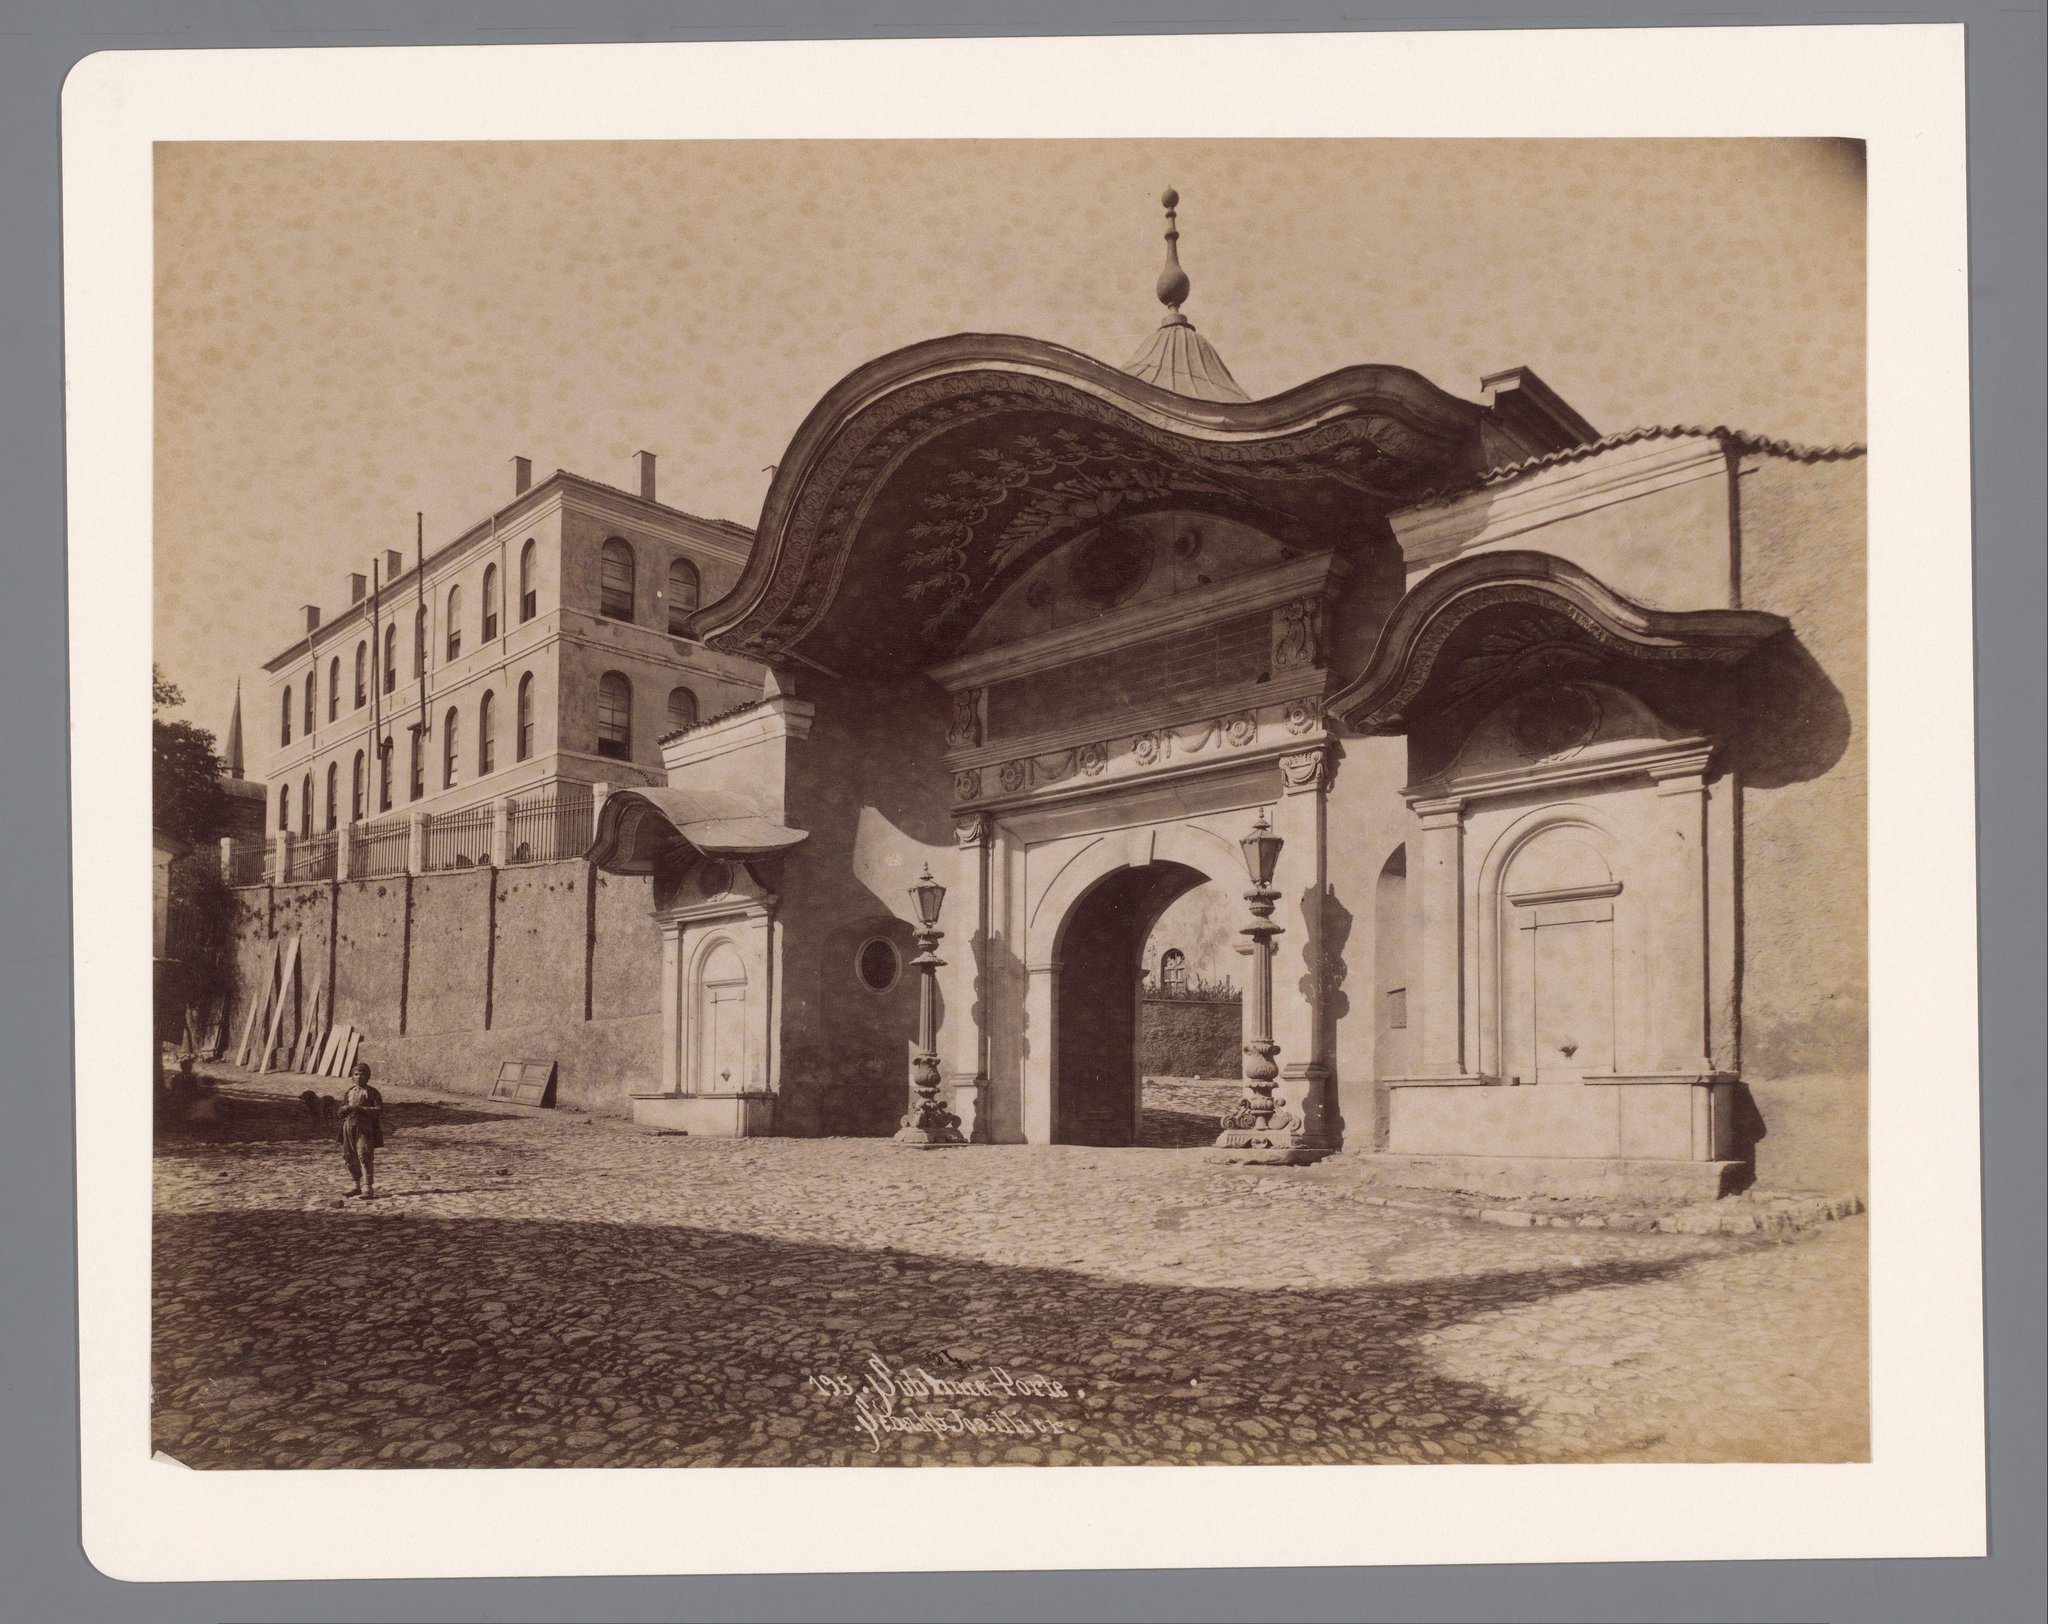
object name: photograph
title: Verheven Porte in Istanboel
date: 1888-1900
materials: paper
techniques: albumen print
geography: istanbul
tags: gate, entrance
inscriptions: number: ‘195.’